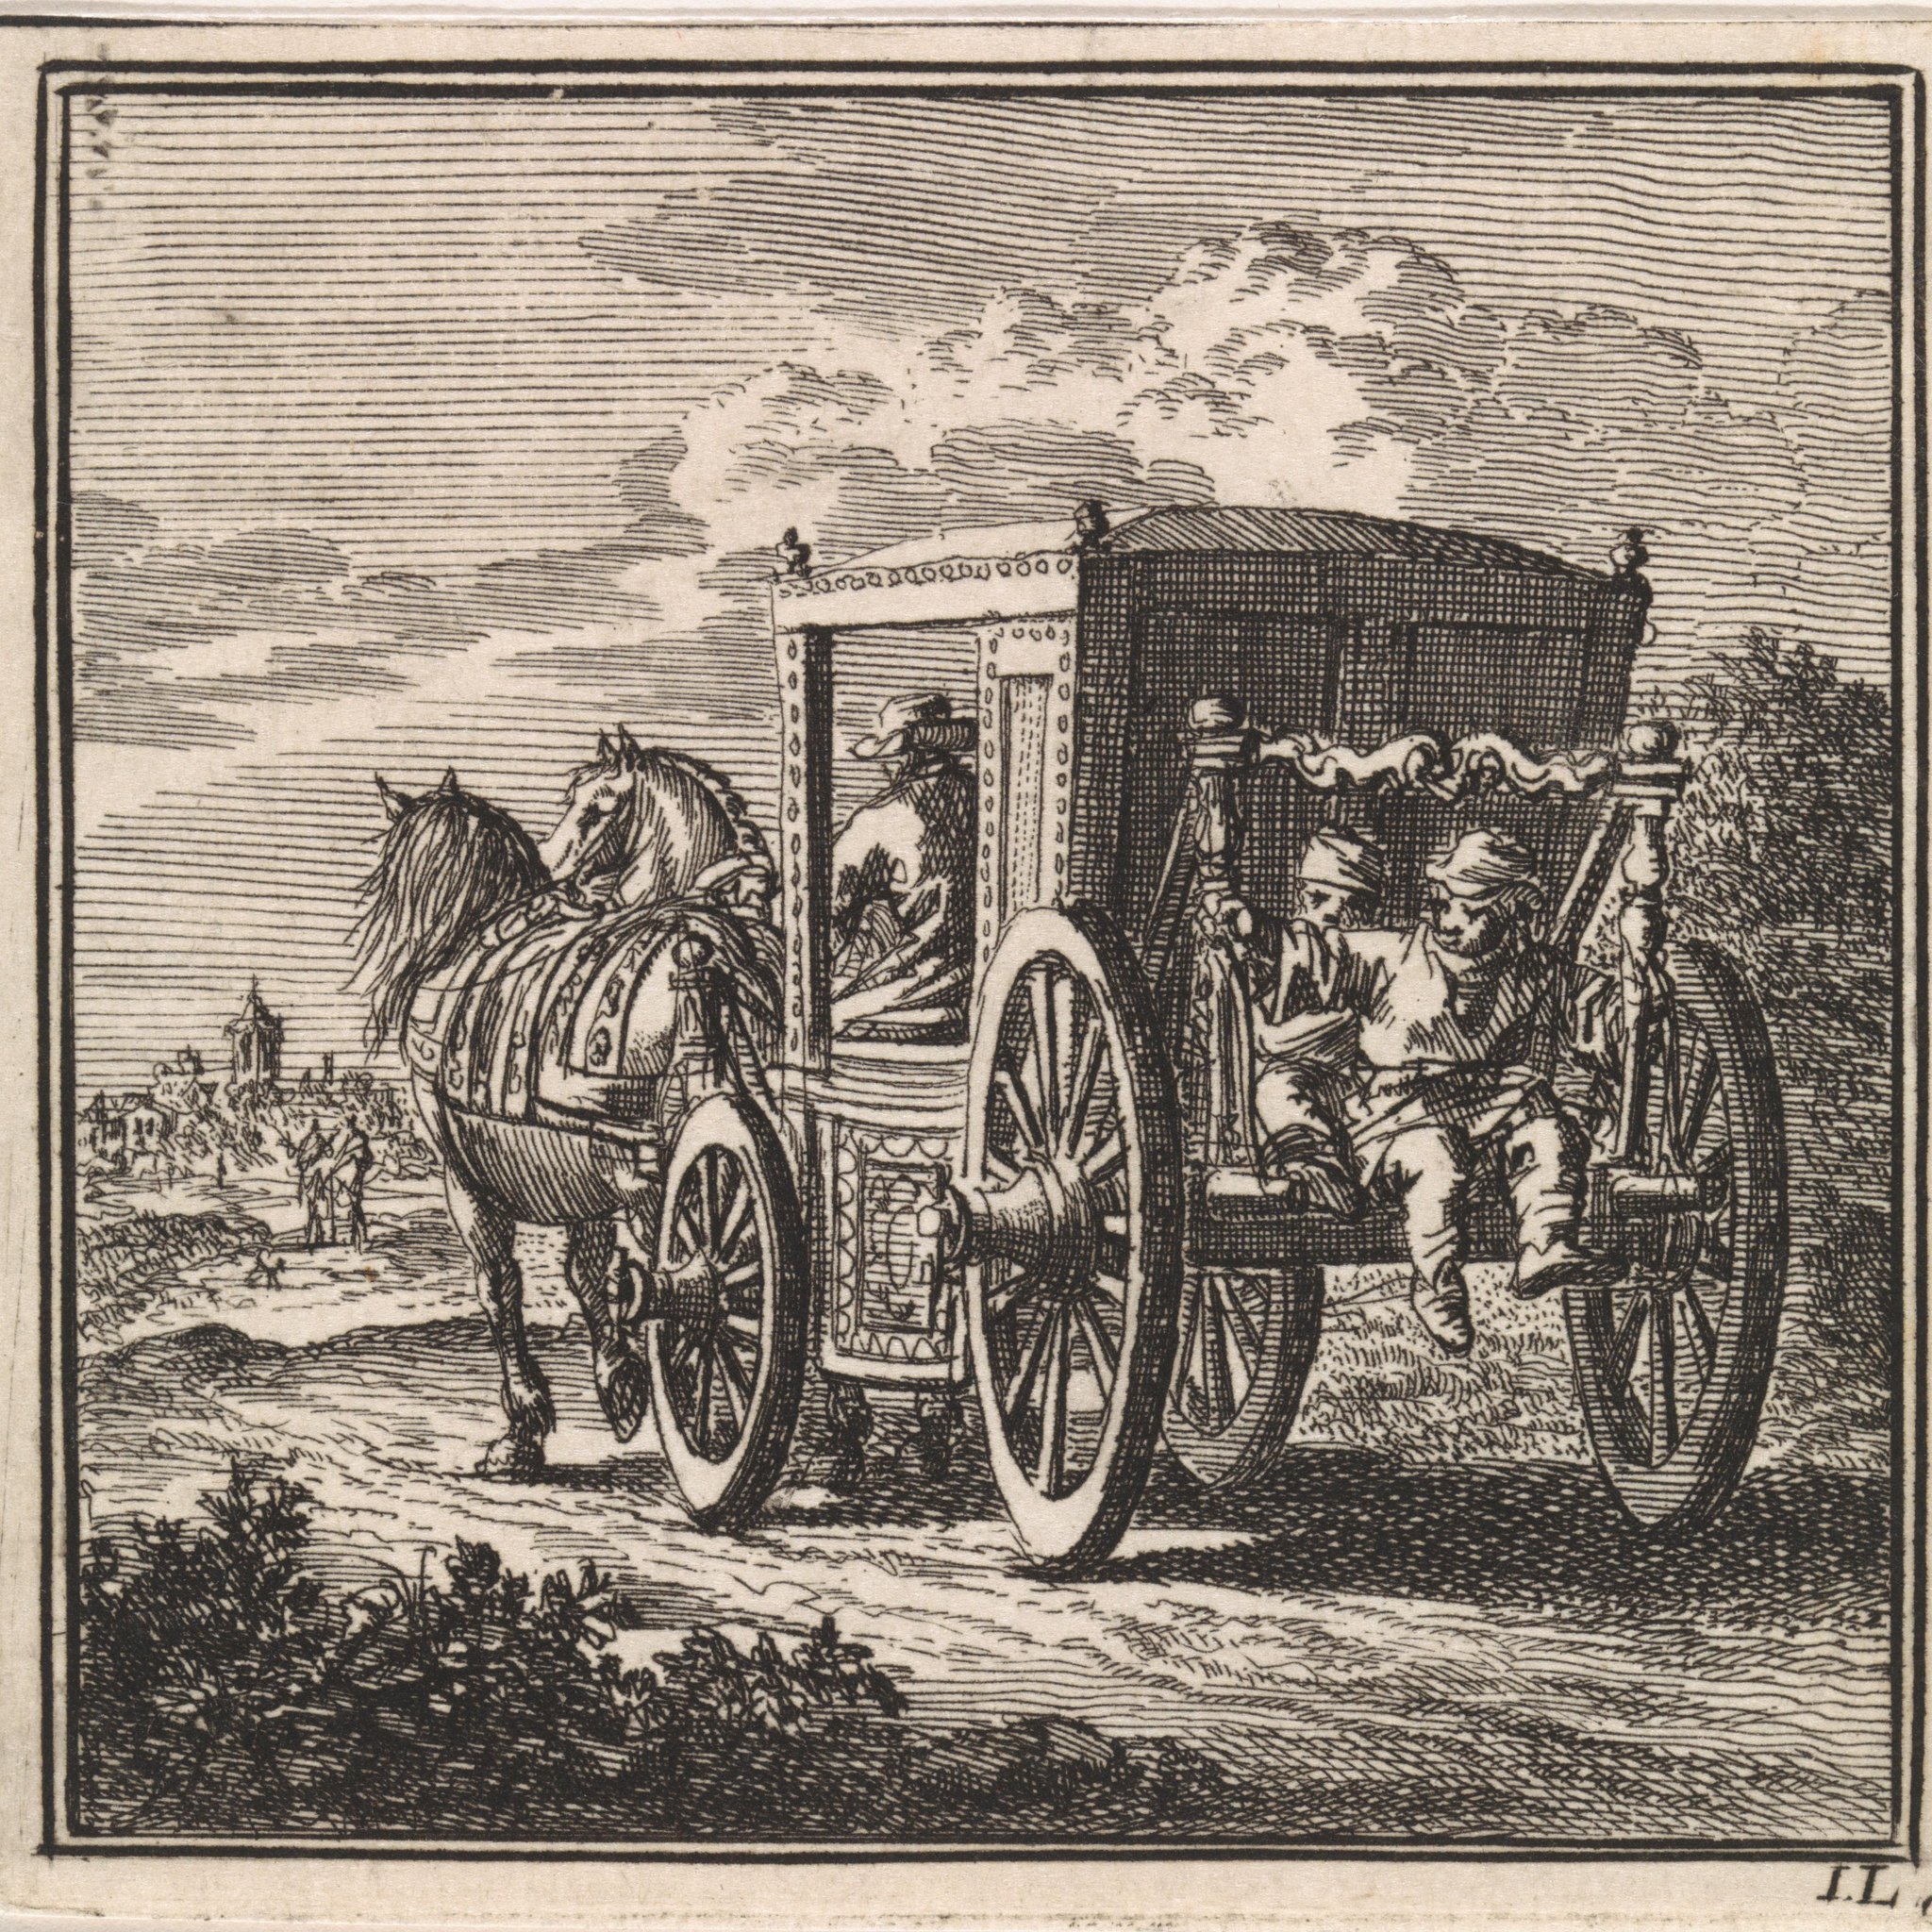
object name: print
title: Twee jongens achterop een koets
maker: jan luyken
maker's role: draughtsman, print maker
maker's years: 1649-1712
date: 1711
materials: paper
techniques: etching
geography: amsterdam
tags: four-wheeled vehicle drawn by two animals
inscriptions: collector's mark: Lugt 2228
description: Illustratie voor: Luyken, Jan. De Bykorf des Gemoeds. Amsterdam: Pieter Arentsz. II (wed.) en Cornelis van der Sys, 1711, p. 134.